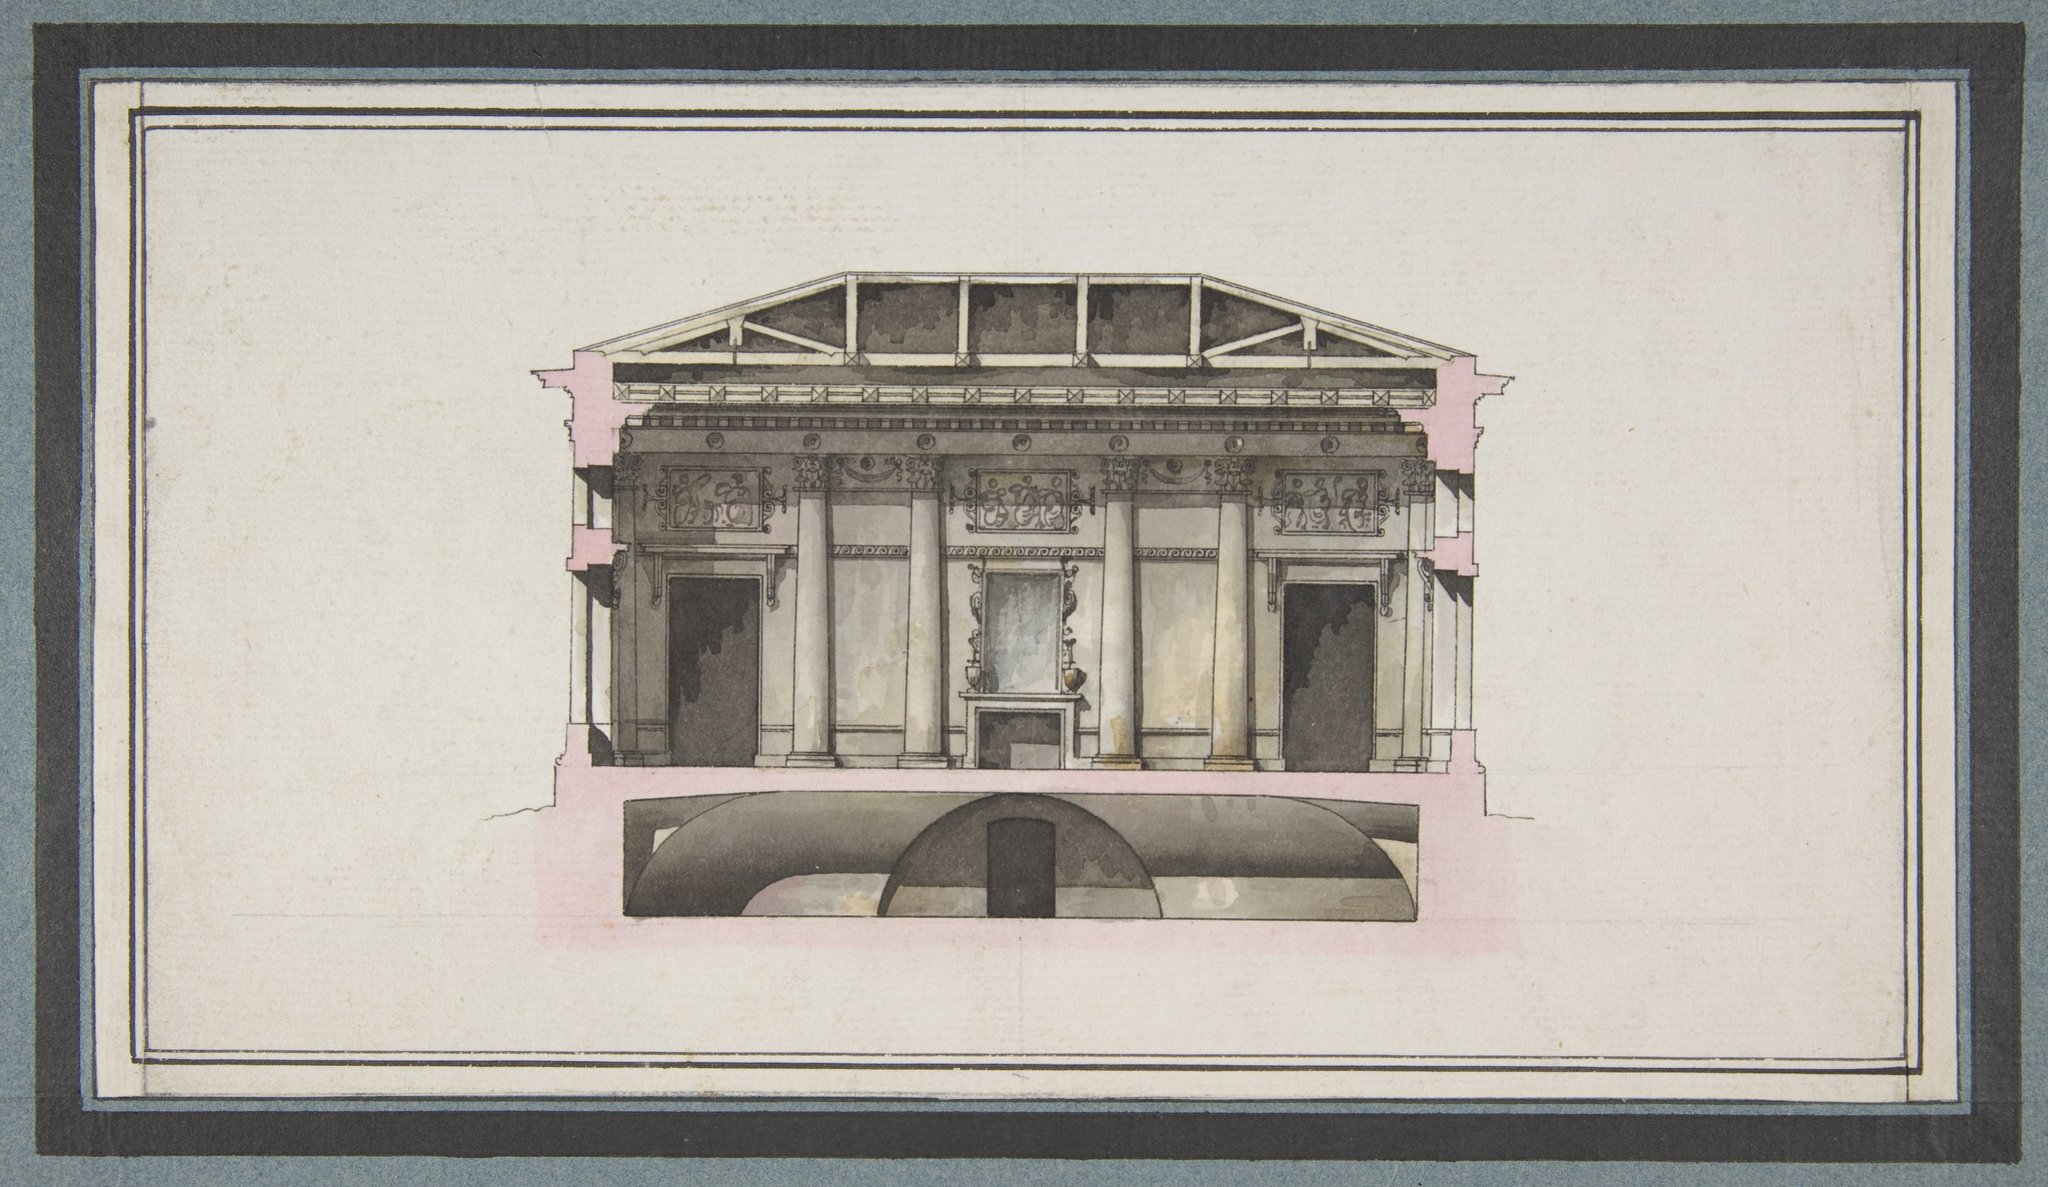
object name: drawing ornament architecture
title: Project for the Alexander Palace, Tsarskoe Selo (Section)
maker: giacomo quarenghi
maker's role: artist and architect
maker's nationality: italian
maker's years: 1744-1817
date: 1744-1817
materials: graphite, ink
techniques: brush, pen, wash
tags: architecture,palaces